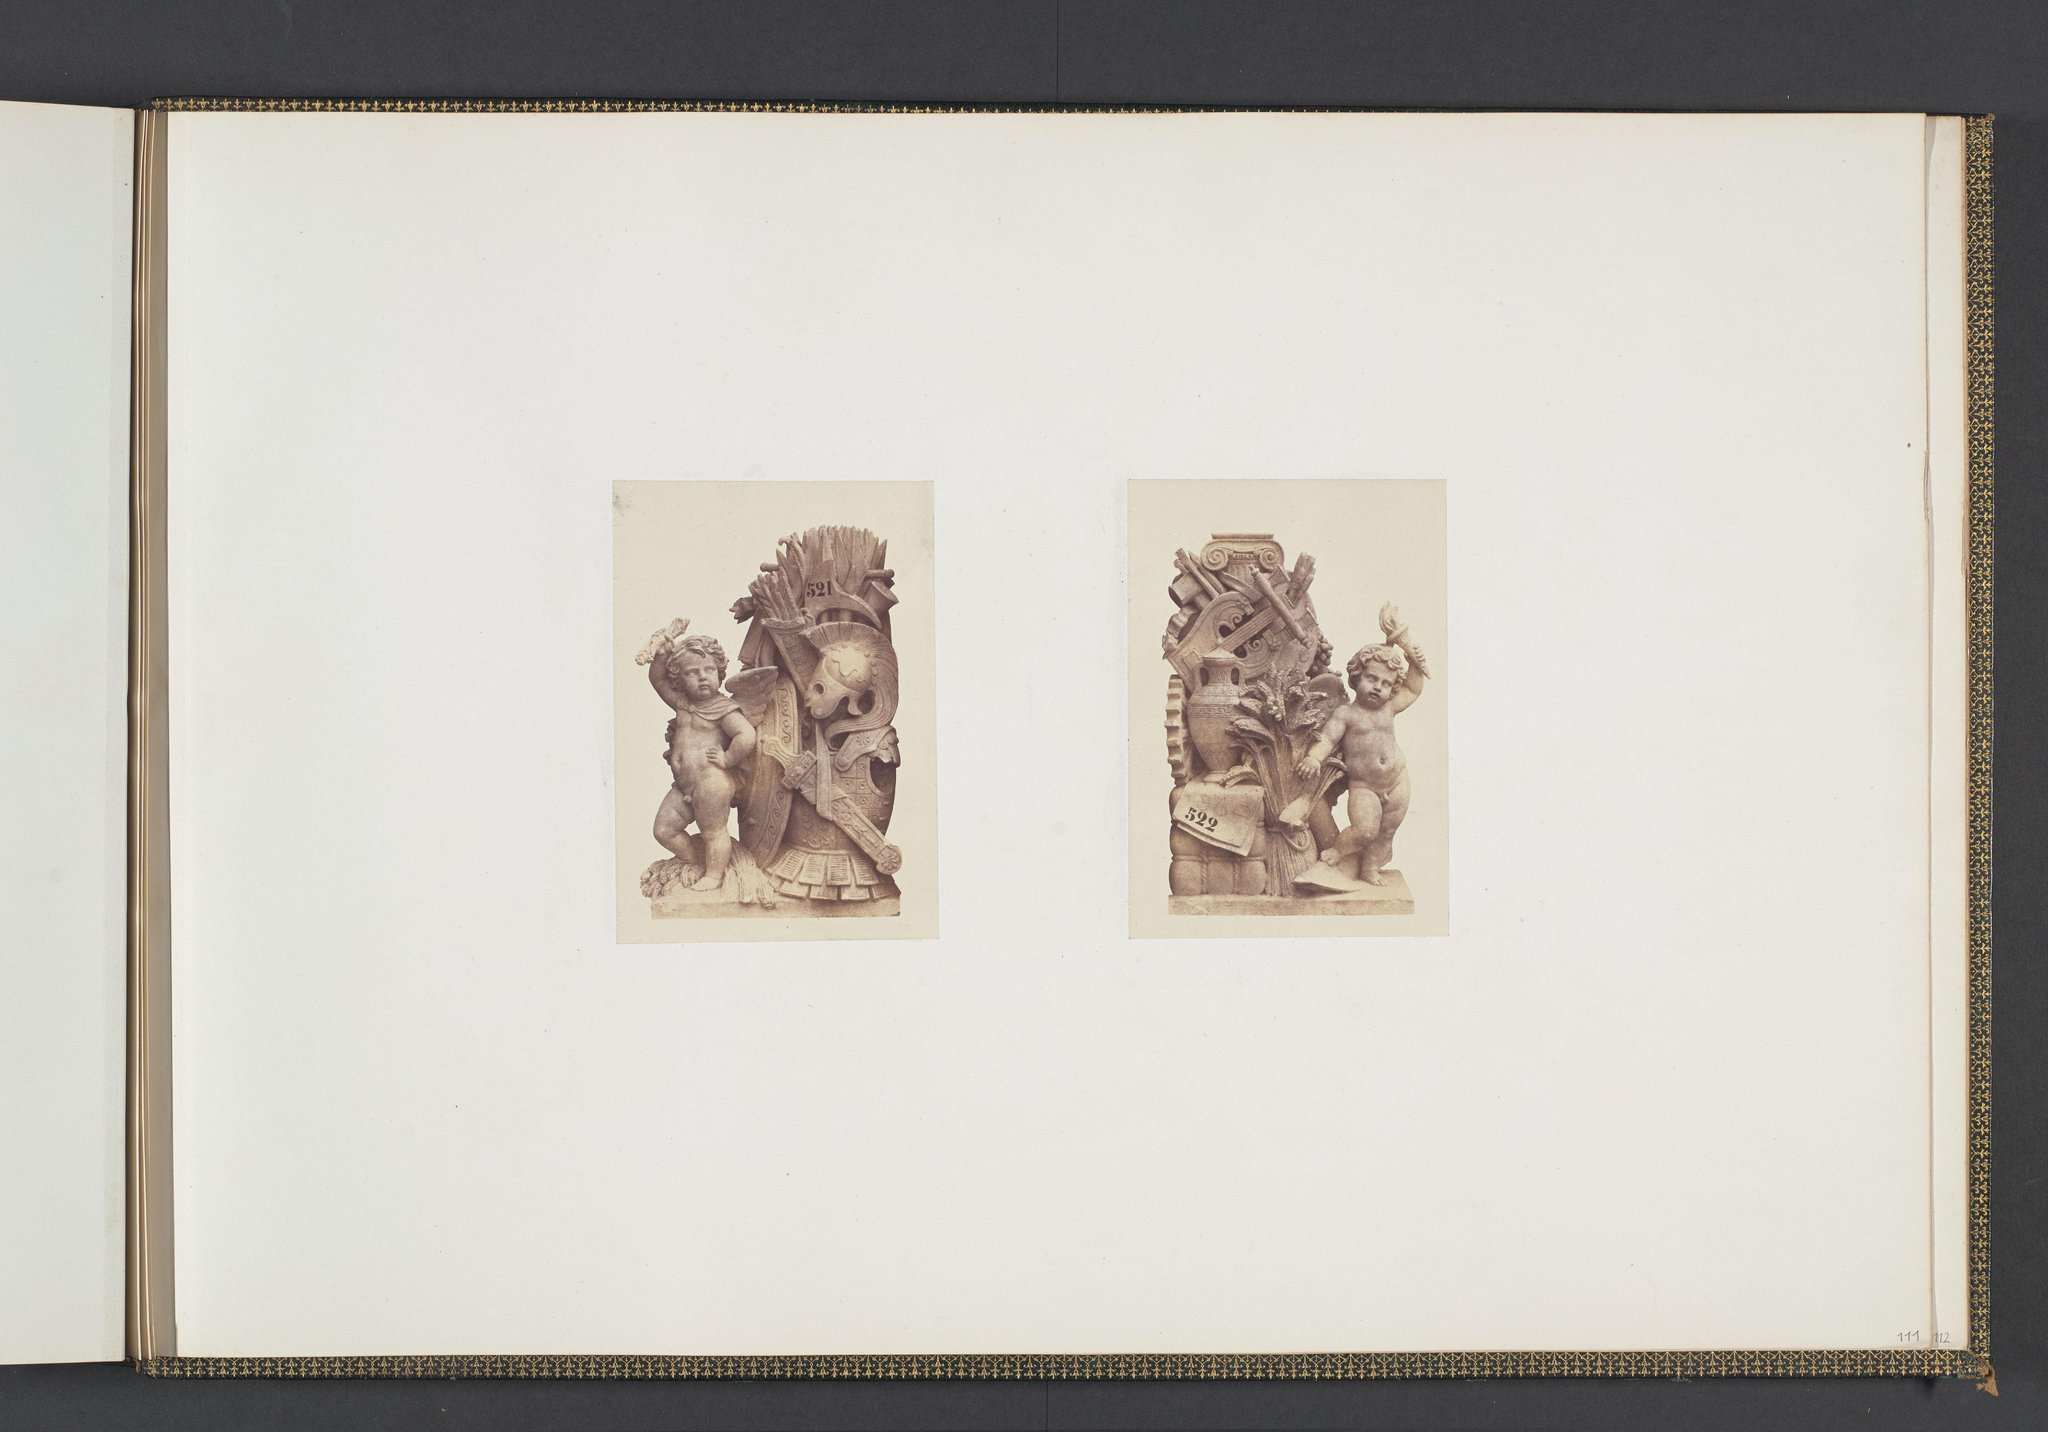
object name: photograph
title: Gipsmodellen voor beeldhouwwerken op het Palais du Louvre: links "La Guerre" door Augustin Alexandre Dumont en rechts "La Paix" door Antoine Etex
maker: édouard denis baldus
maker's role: fotograaf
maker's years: 1813-1889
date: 1855-1857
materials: paper, photographic support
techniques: salted paper print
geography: paris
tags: piece of sculpture, reproduction of a piece of sculpture, permanent exhibition, museum, paris, tuileries palace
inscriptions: number: ‘521 en 522’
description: Onderdeel van Réunion des Tuileries au Louvre 1852-1857, album 2.